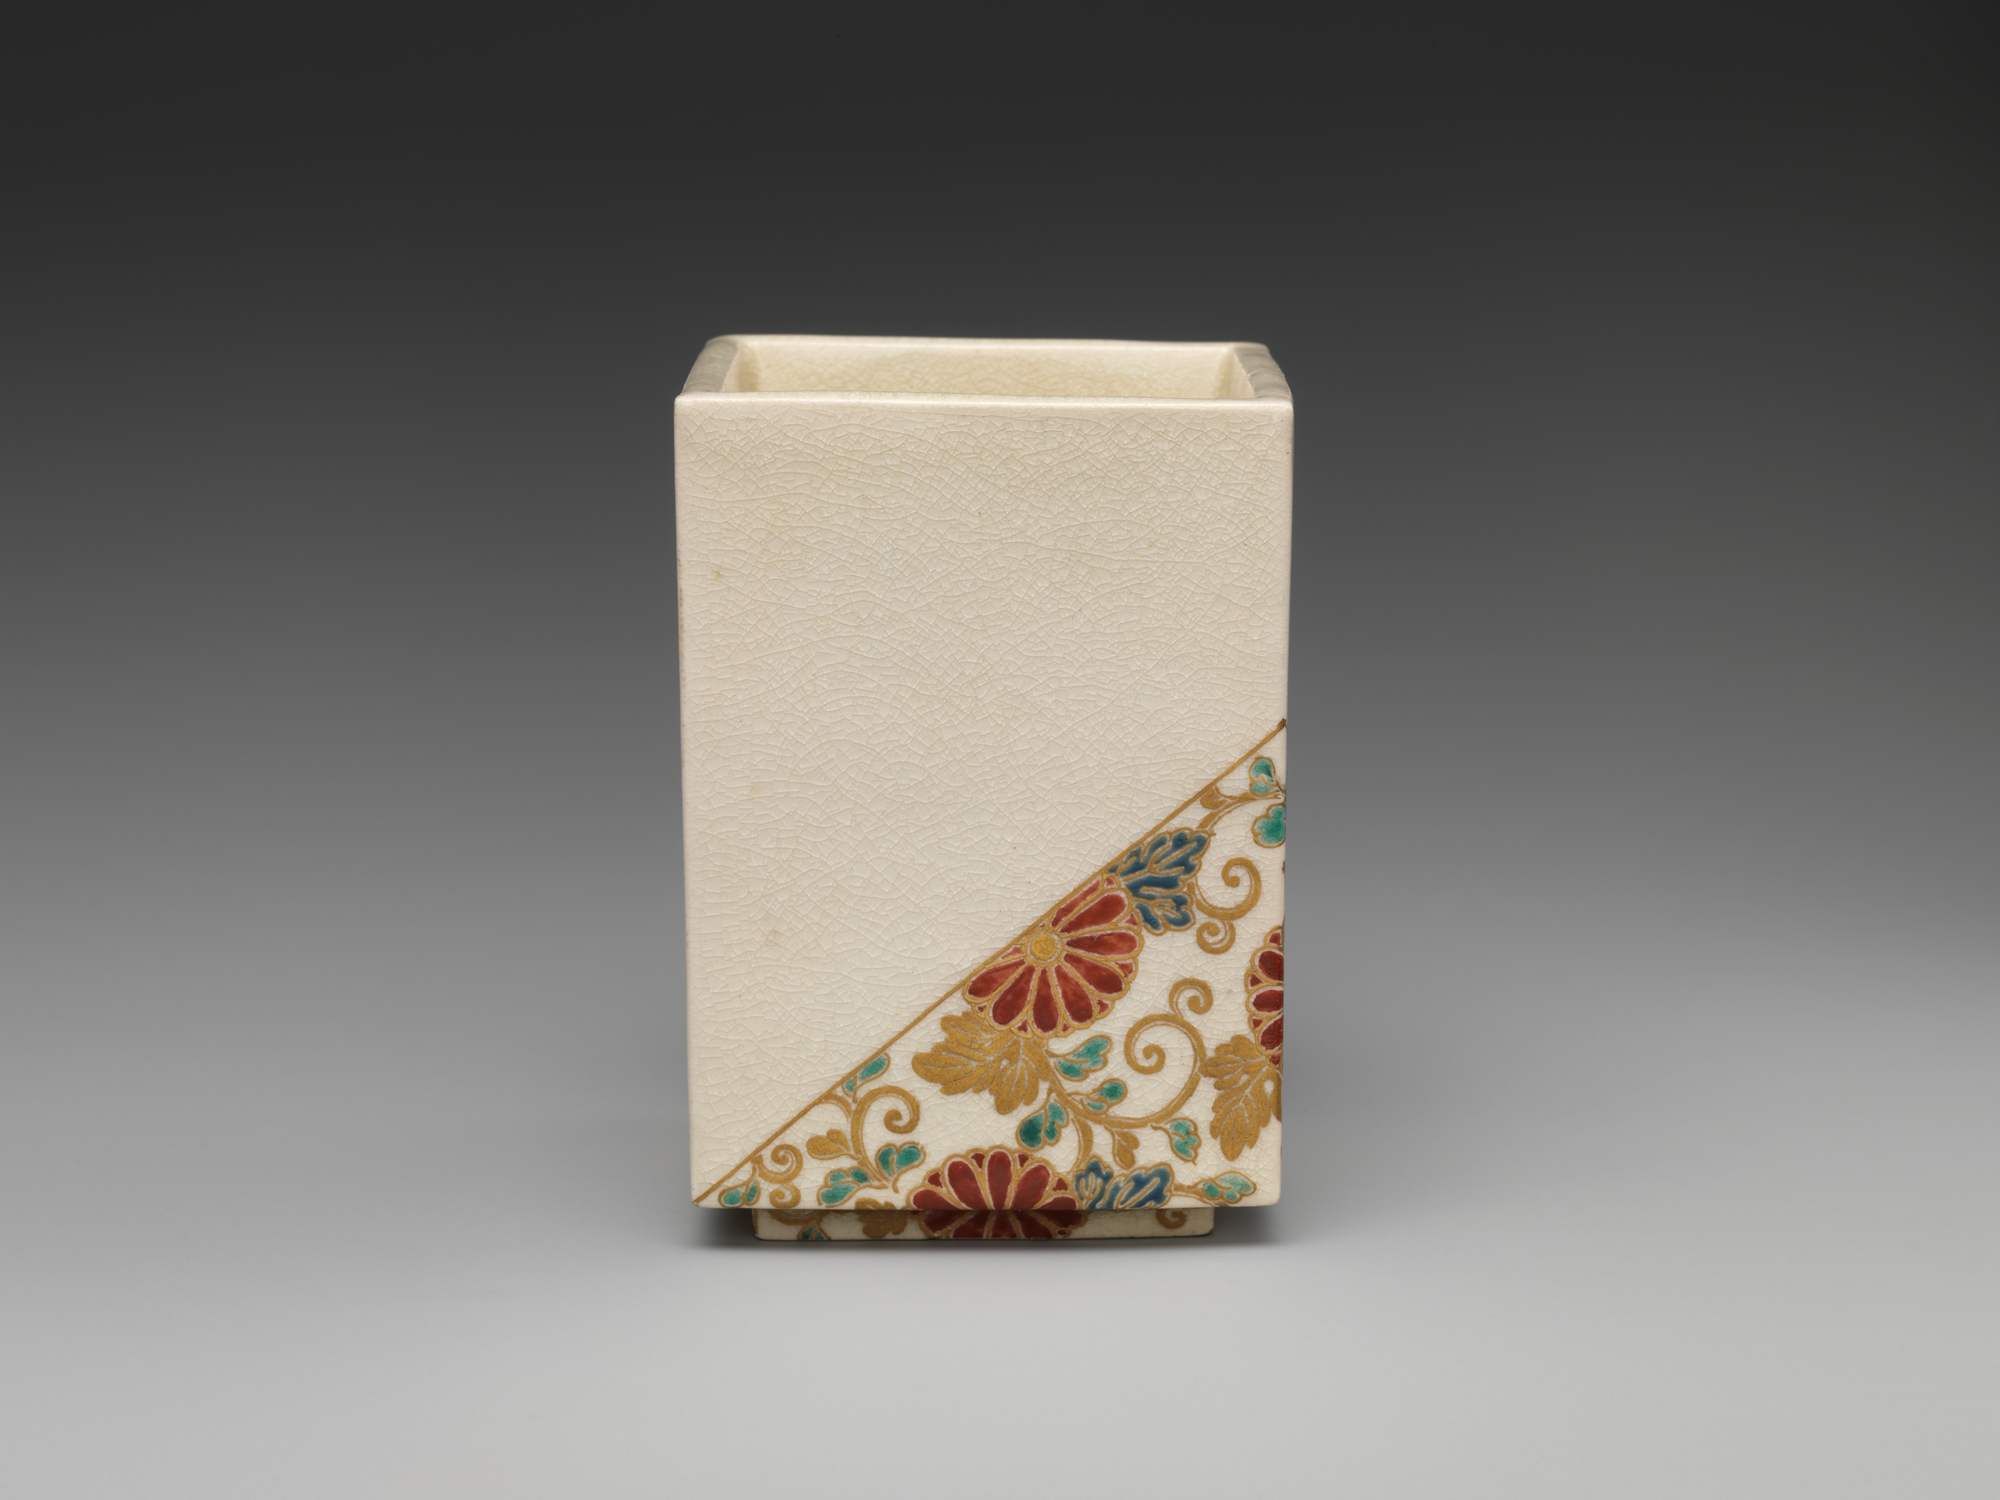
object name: container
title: Ninsei-style Serving Container (Mukōzuke)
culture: japanese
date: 1868-1912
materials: enamel, stoneware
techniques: overglaze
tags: flowers